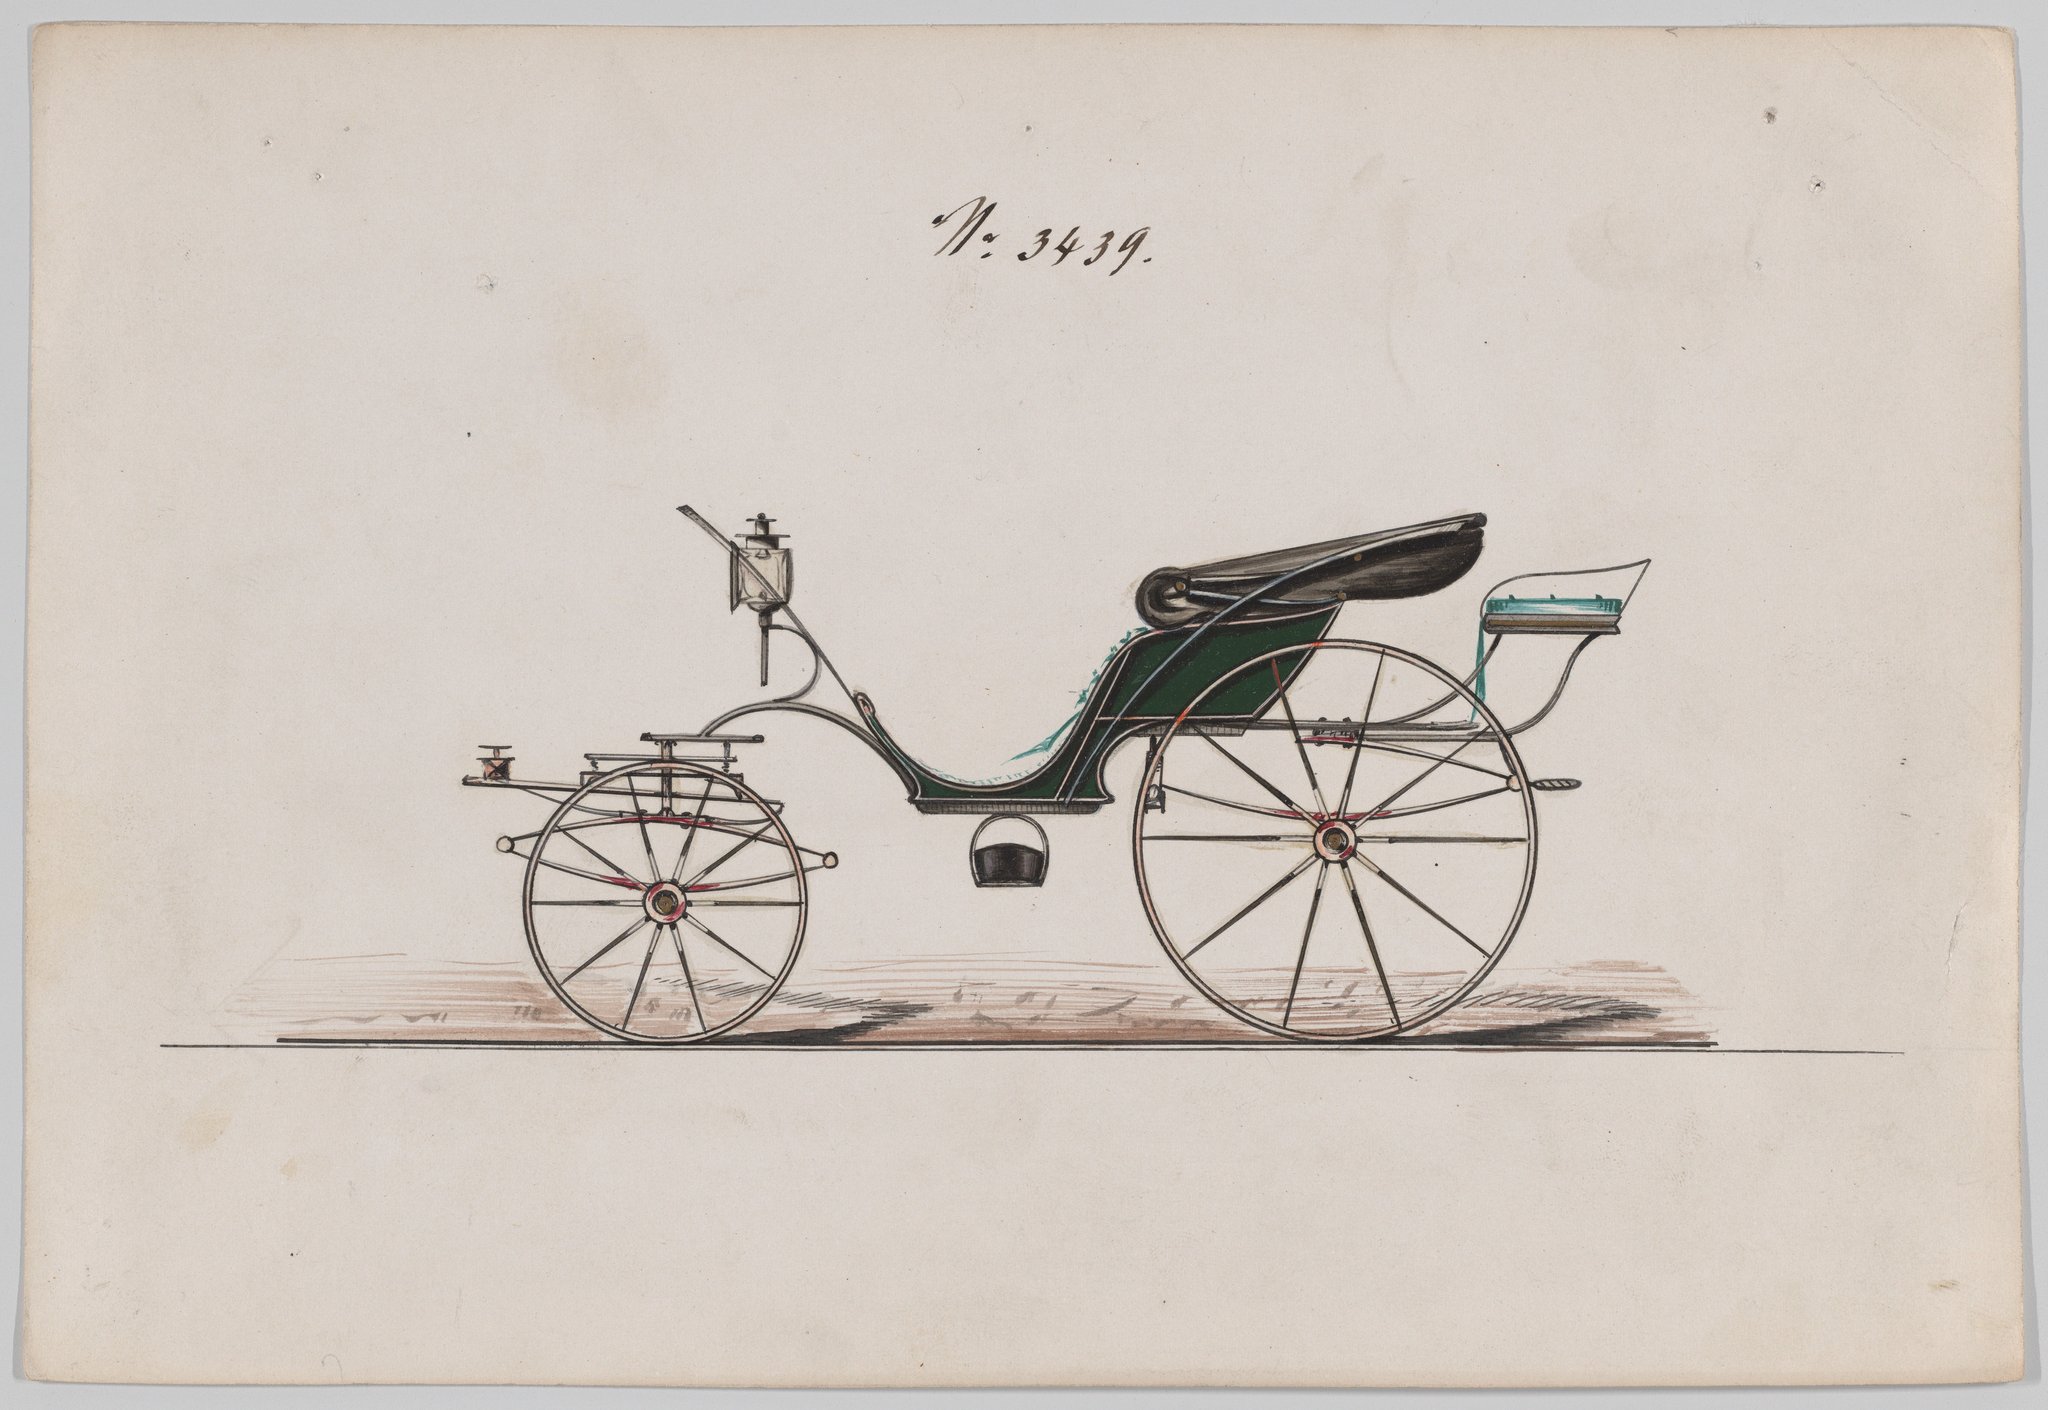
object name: drawing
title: Design for Pony Phaeton, no. 3439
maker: brewster & co.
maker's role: manufacturer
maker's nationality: american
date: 1878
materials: gouache, gum arabic, ink, watercolor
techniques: pen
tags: carriages